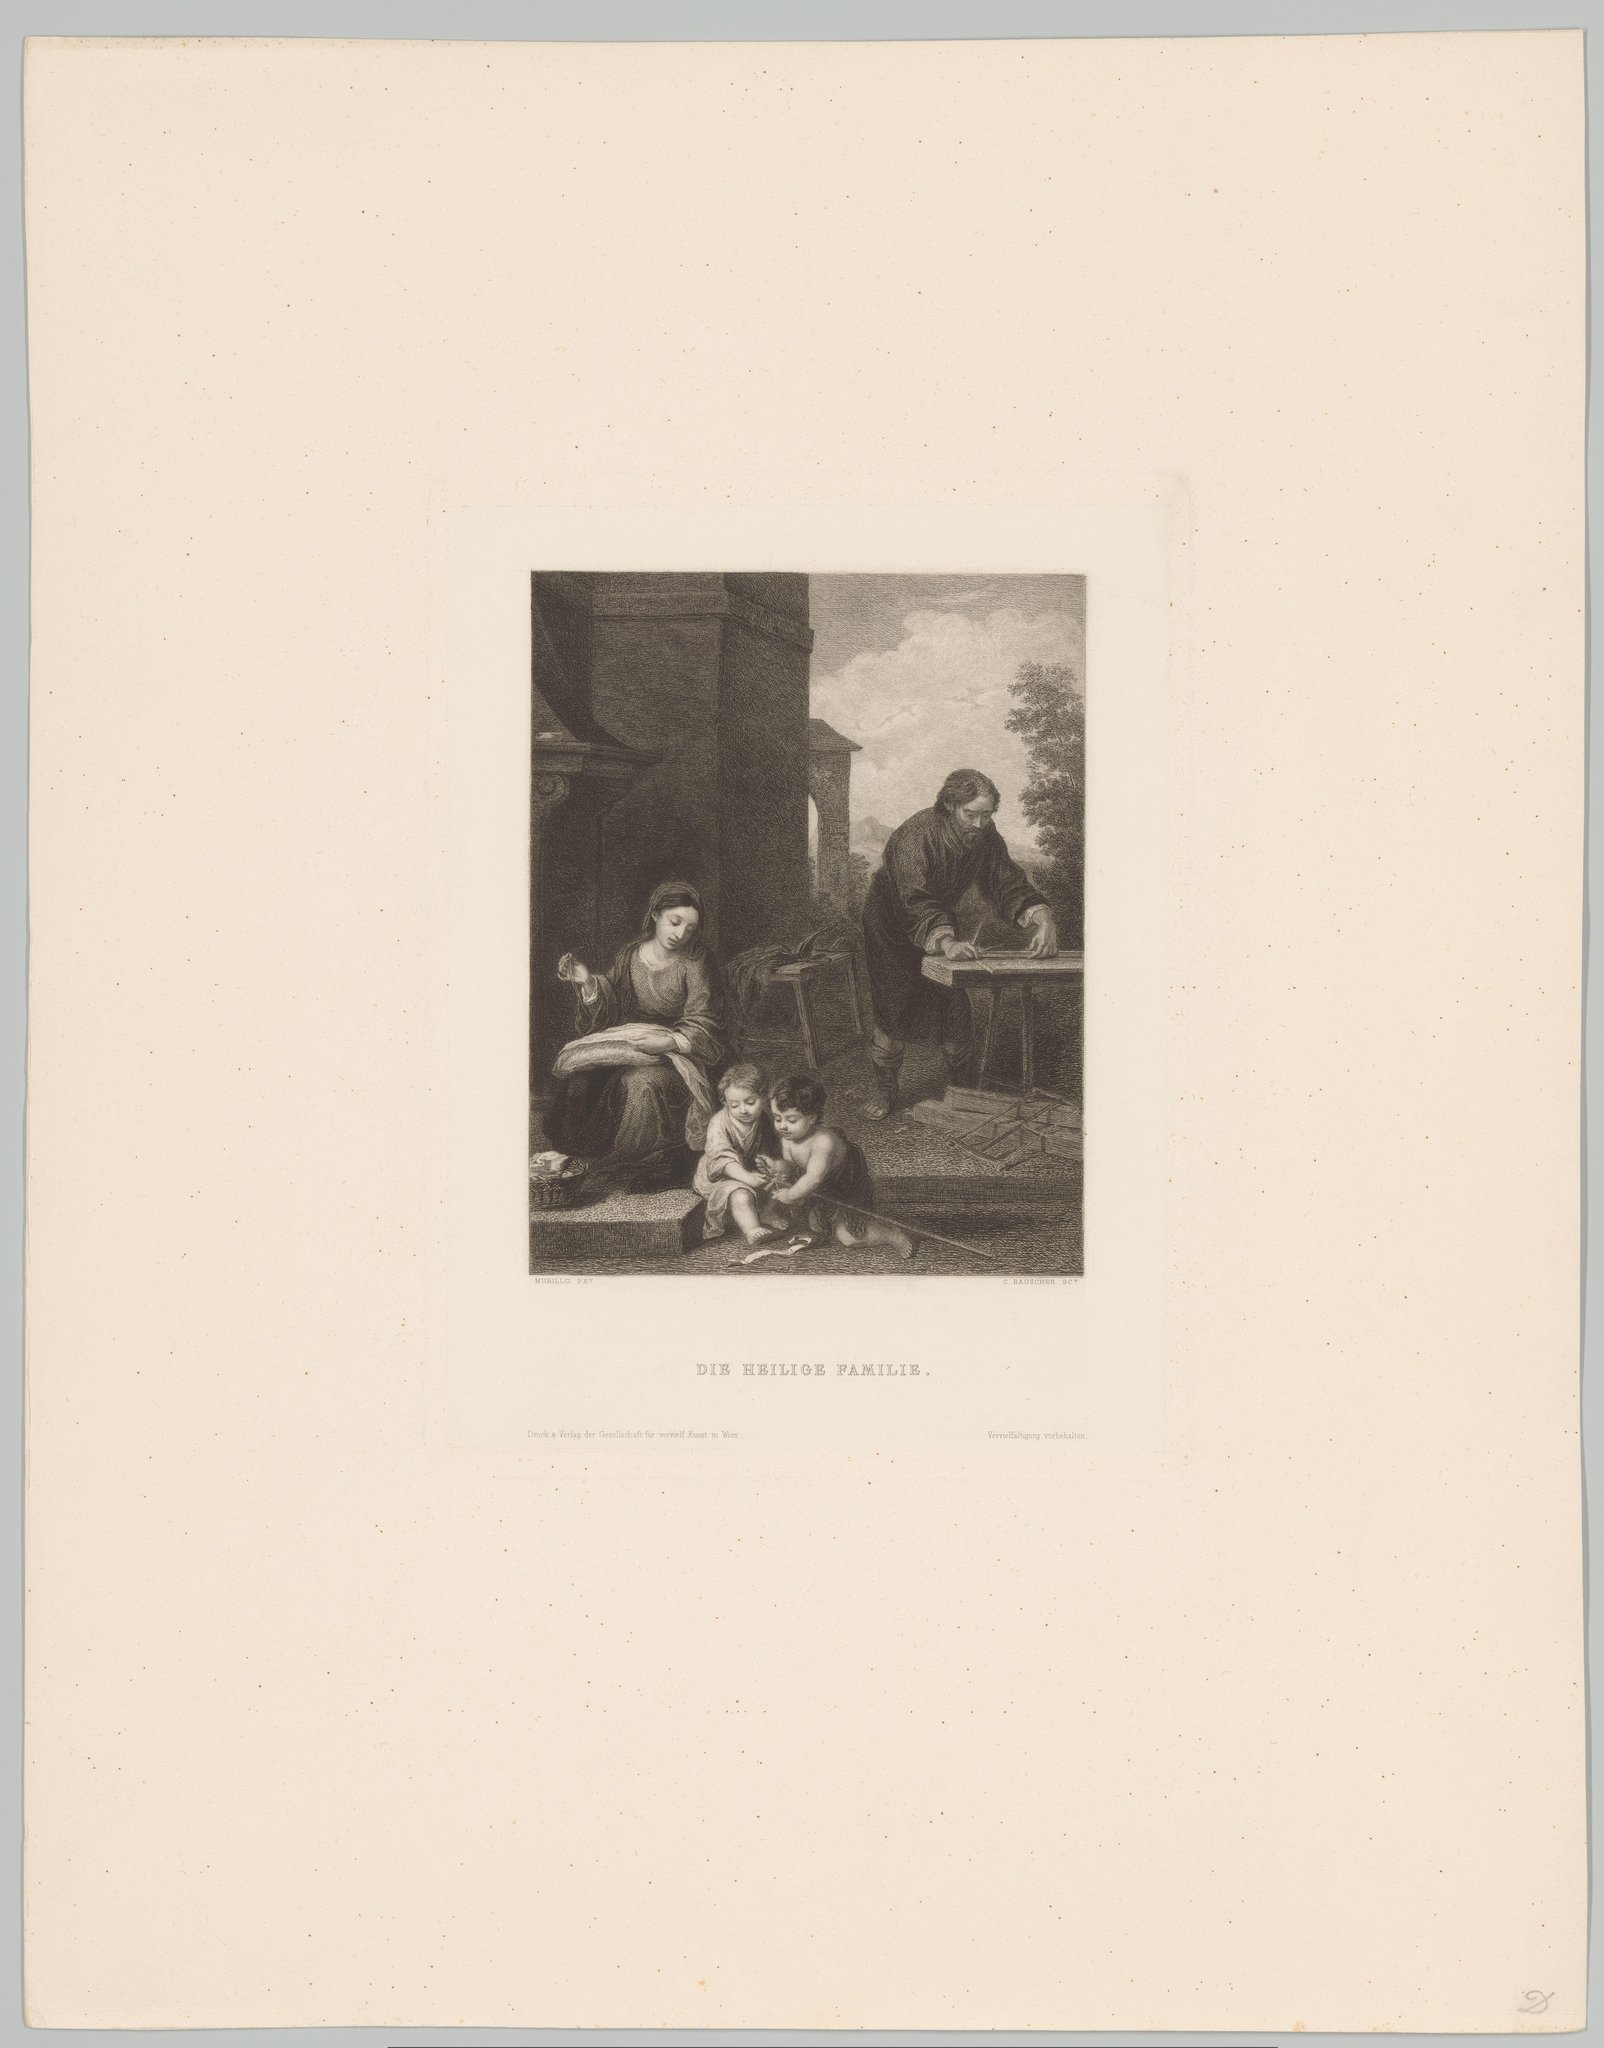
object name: print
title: Heilige Familie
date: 1851-1899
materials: paper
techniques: engraving, etching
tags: holy family, and derived representations